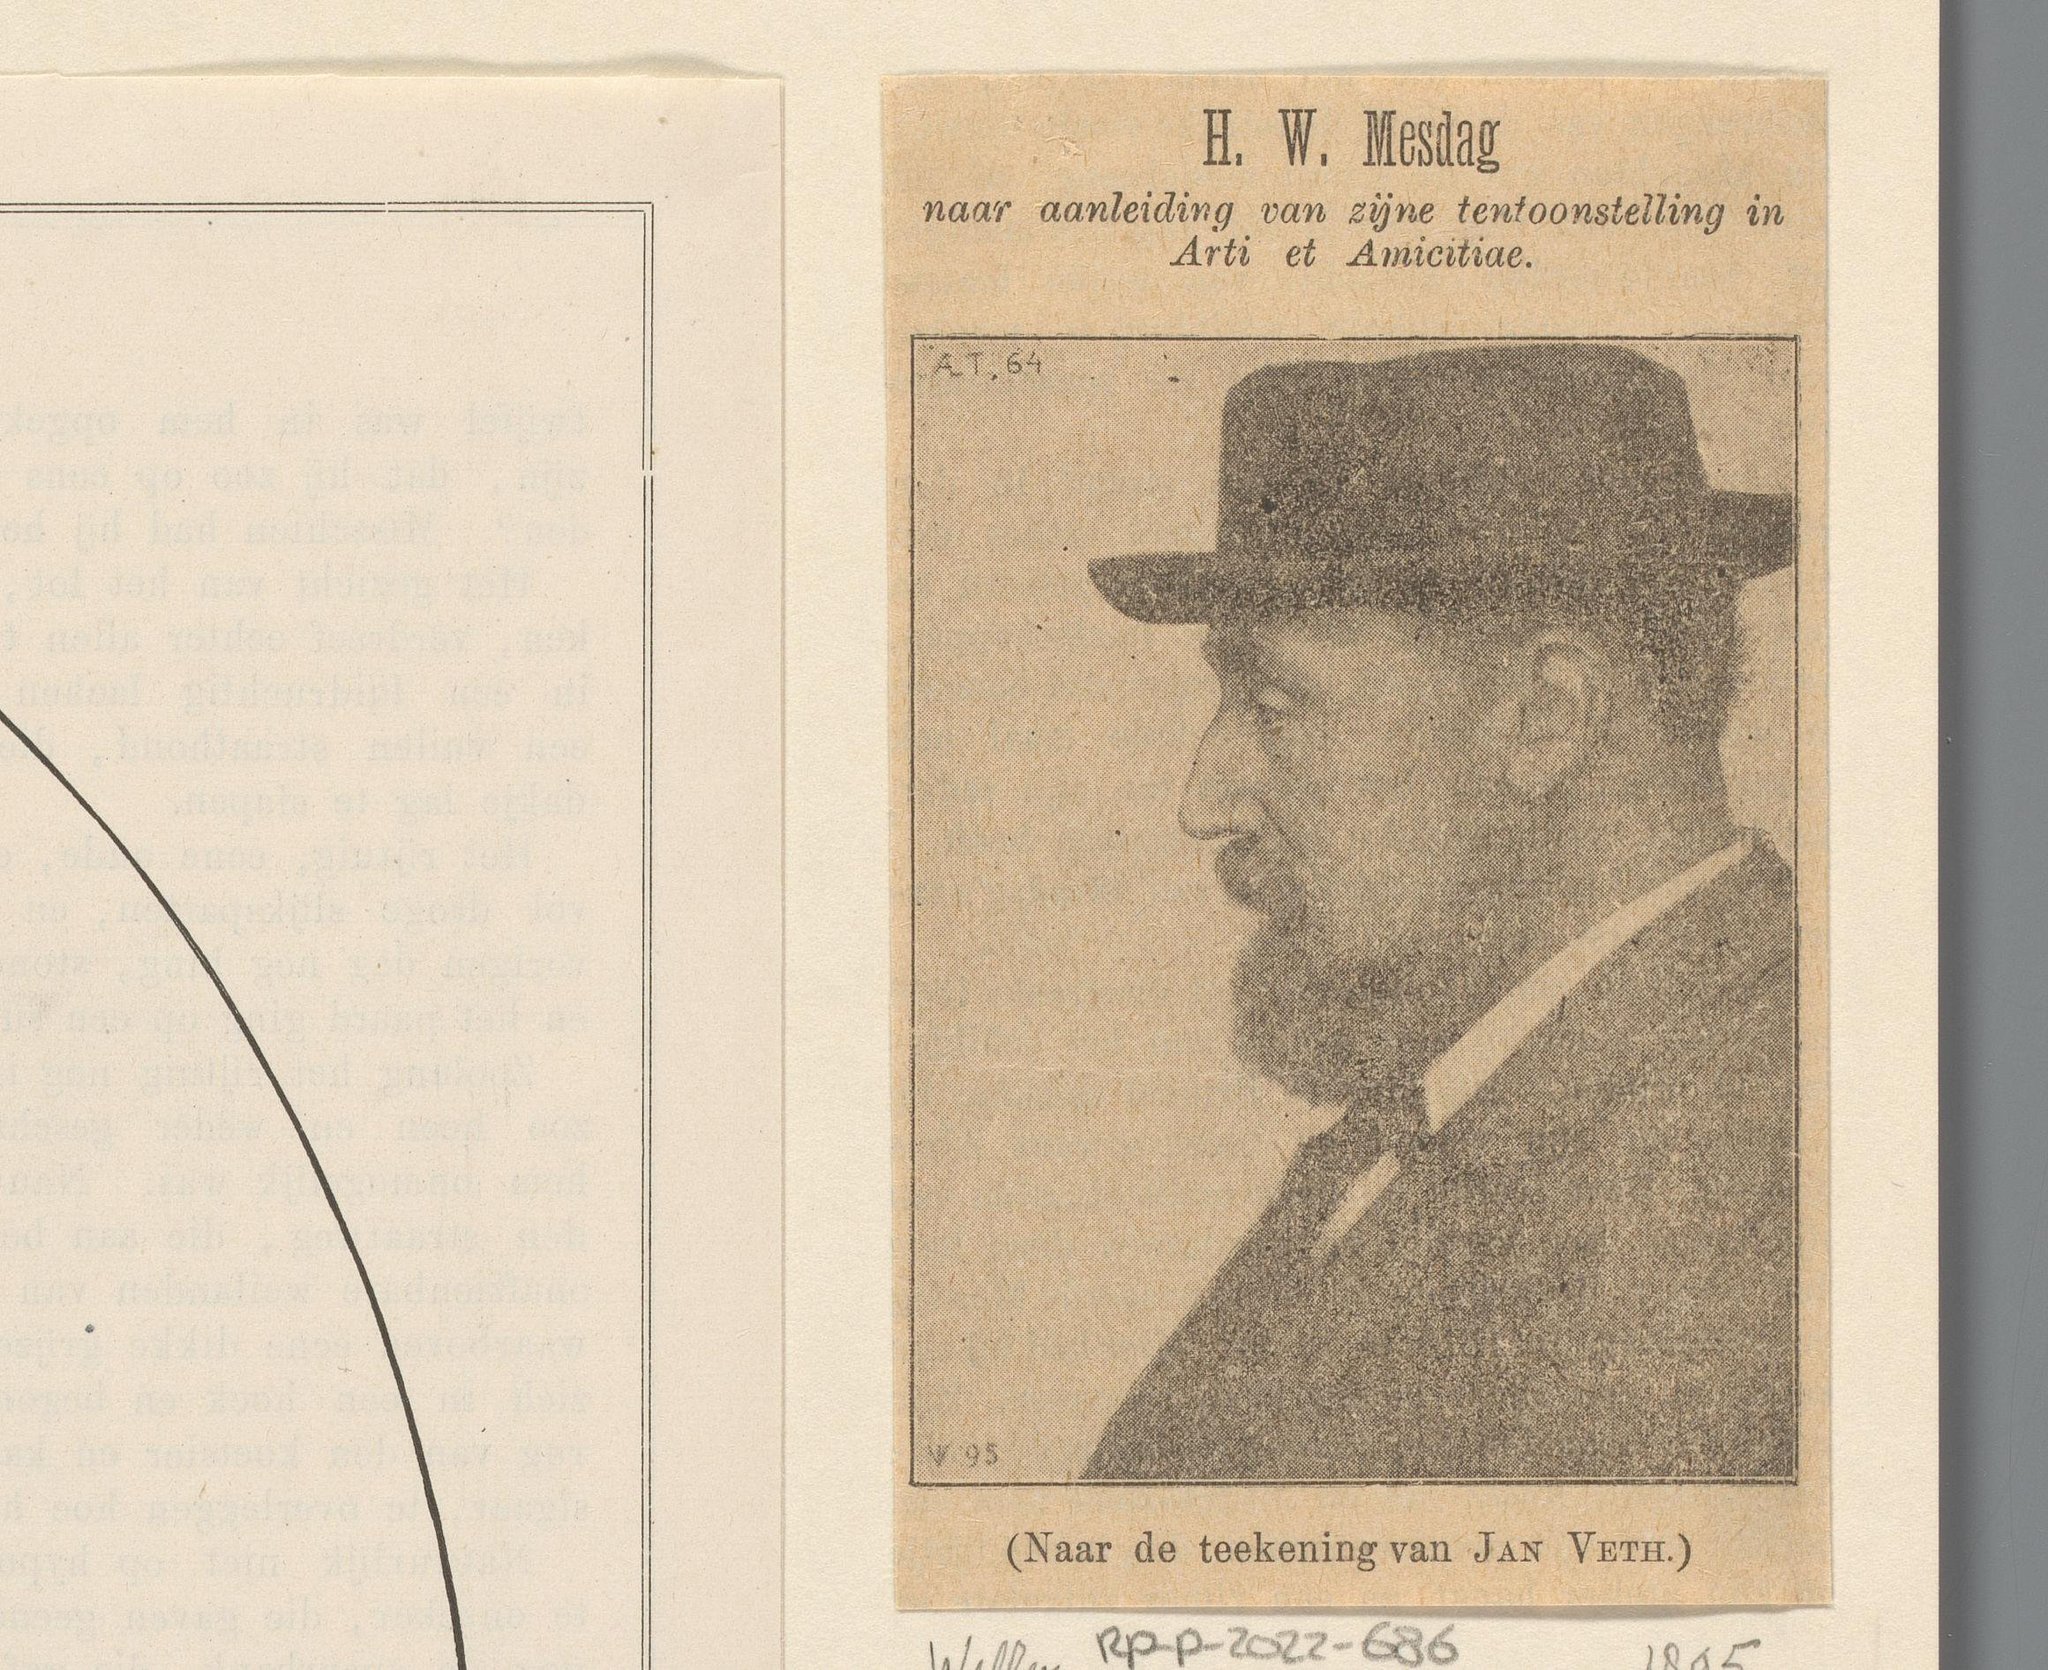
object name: photomechanical print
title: Portret van Hendrik Willem Mesdag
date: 1895-1910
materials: paper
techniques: letterpress printing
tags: the hague, painter, print maker, draughtsman, hendrik willem mesdag, historical persons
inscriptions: collector's mark: Lugt 2228, collector's mark: Lugt 2760